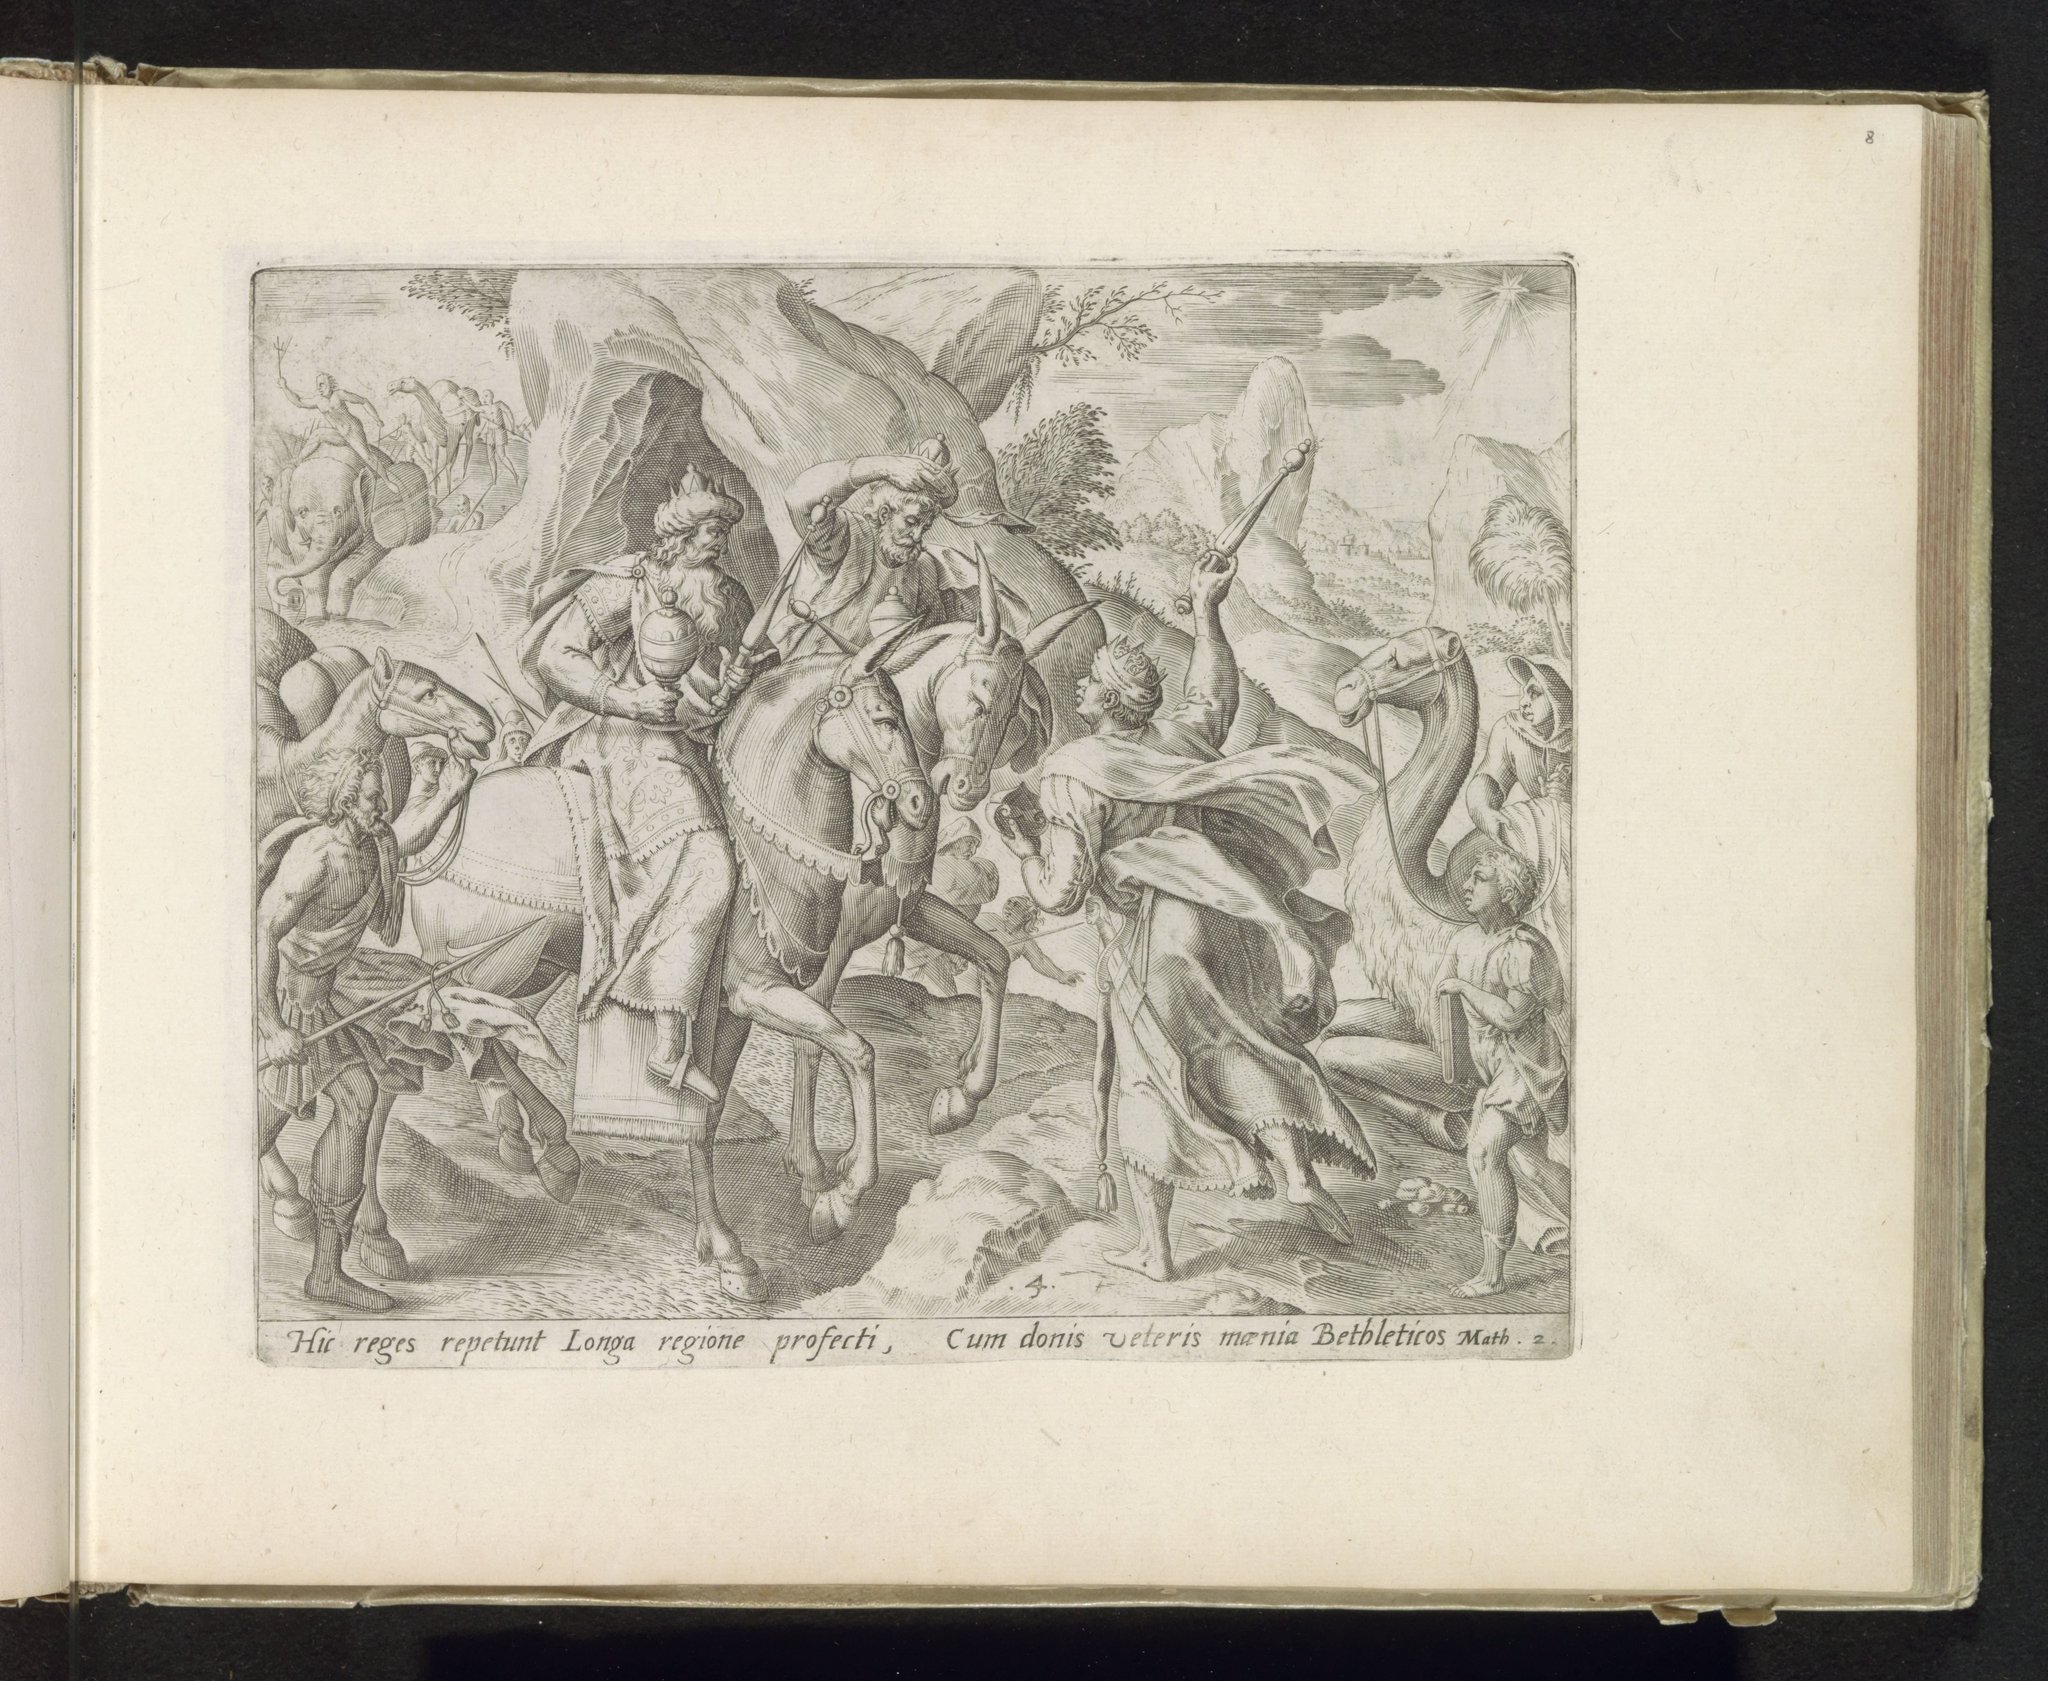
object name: print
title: Thesaurus novi Testamenti elegantissimis iconibus expressus continens historias atque miracula doni nostri Iesu Christi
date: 1585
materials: paper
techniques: engraving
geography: antwerp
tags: journey of the three wise men to jerusalem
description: De drie koningen ontmoeten elkaar op een kruispunt en volgen samen de ster van Betlehem. De zwarte koning wijst met zijn scepter op de ster. Onder de voorstelling een verwijzing in het Latijn naar de Bijbeltekst in Mat. 2. Deze prent maakt deel uit van een album.